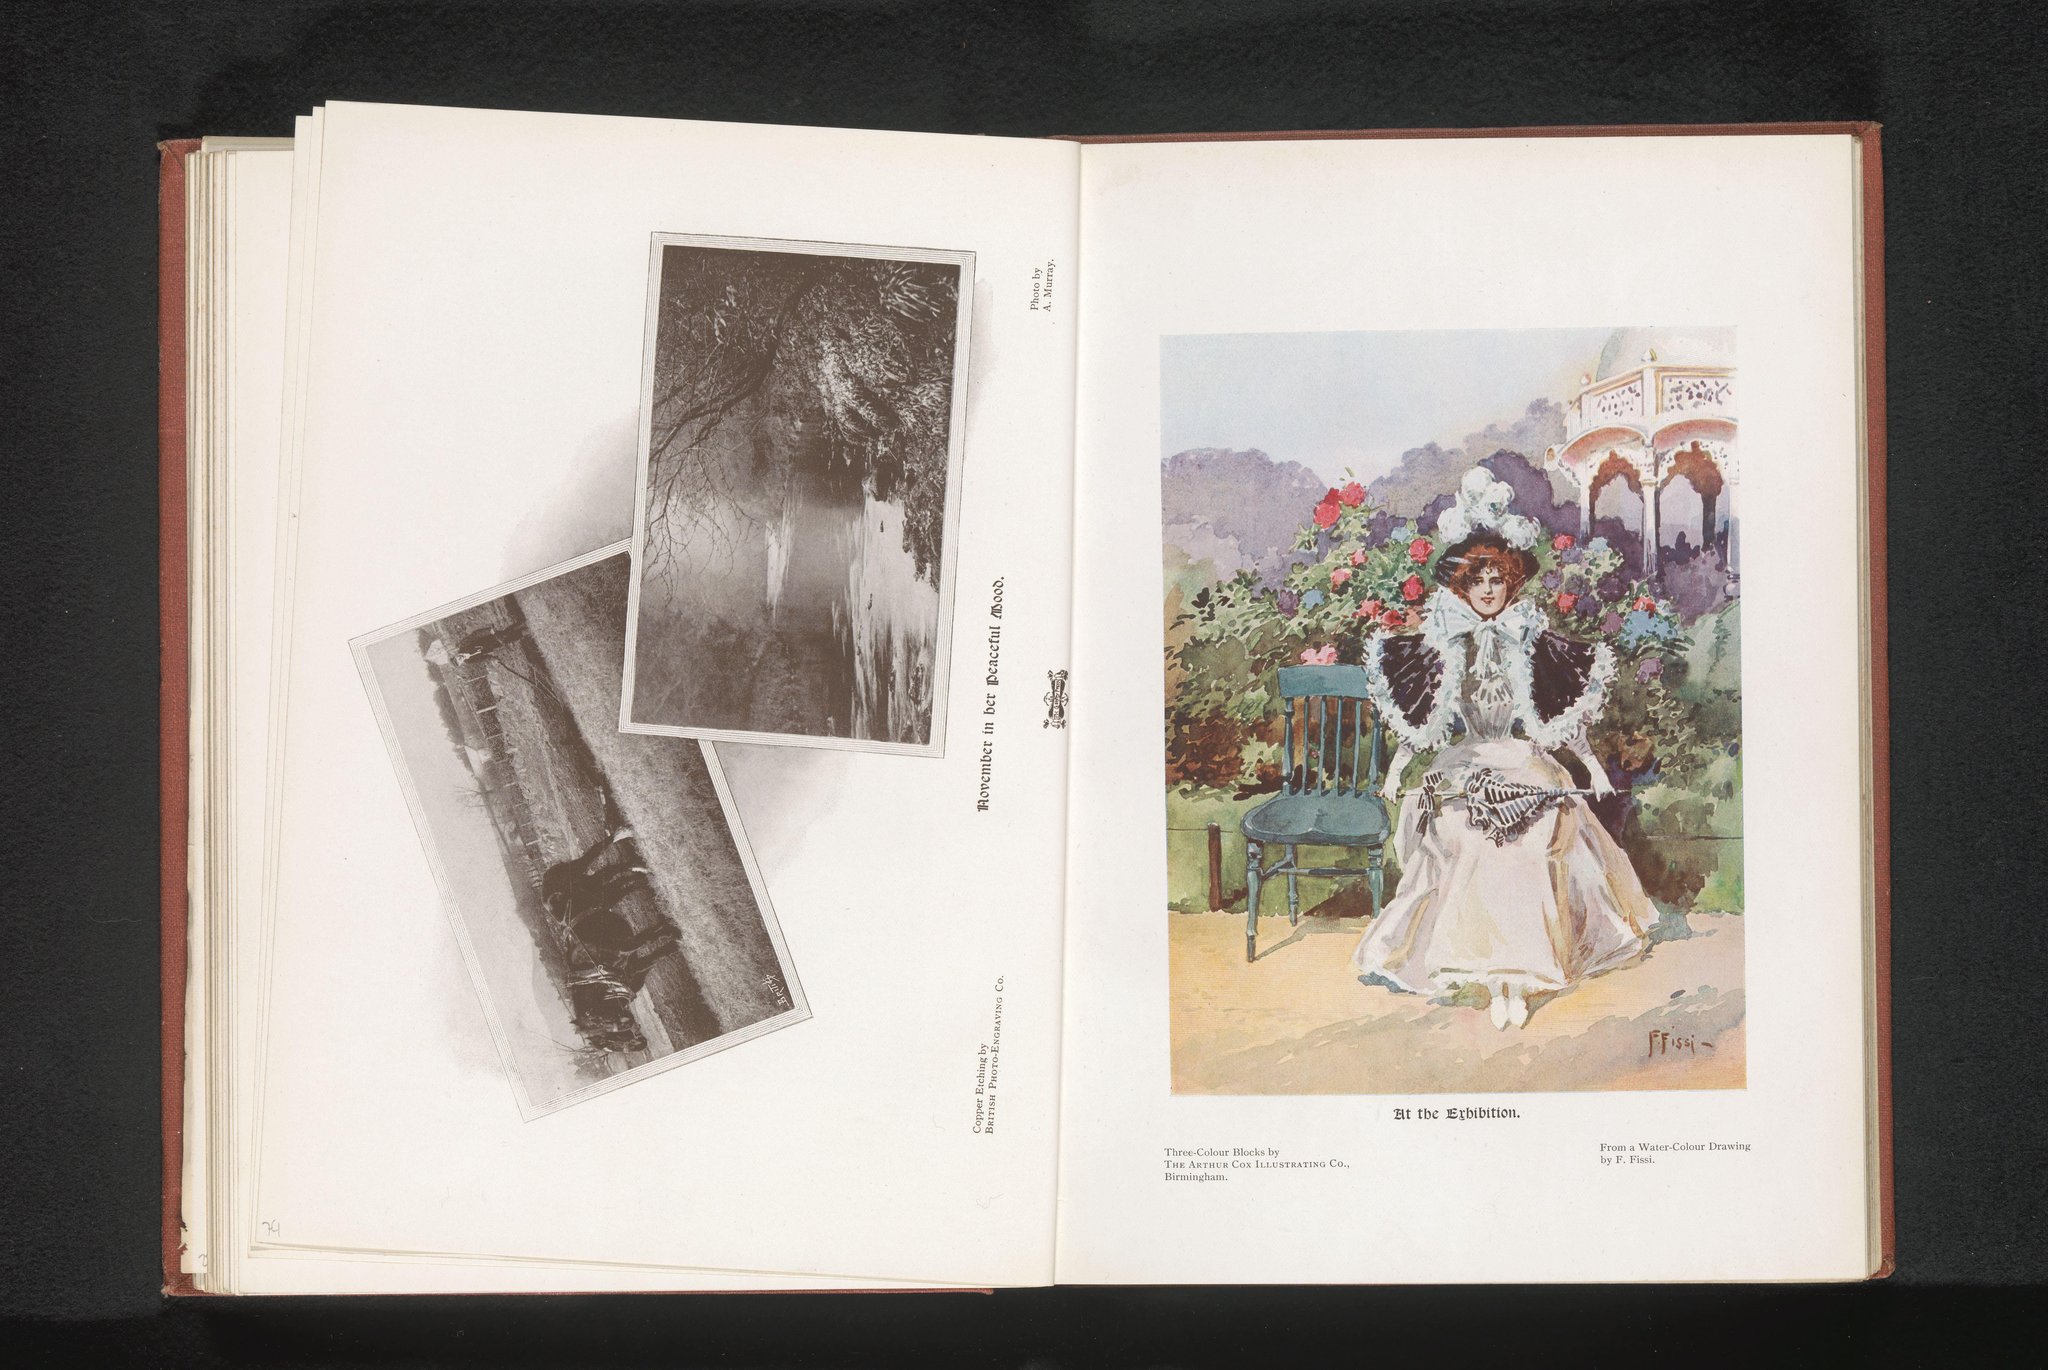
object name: photomechanical print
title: November in her peaceful mood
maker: a. murray (fotograaf)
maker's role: fotograaf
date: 1895-1900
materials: paper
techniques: autotype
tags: river, ploughing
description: Prent op vierde ongenummerde pagina na pagina 56.